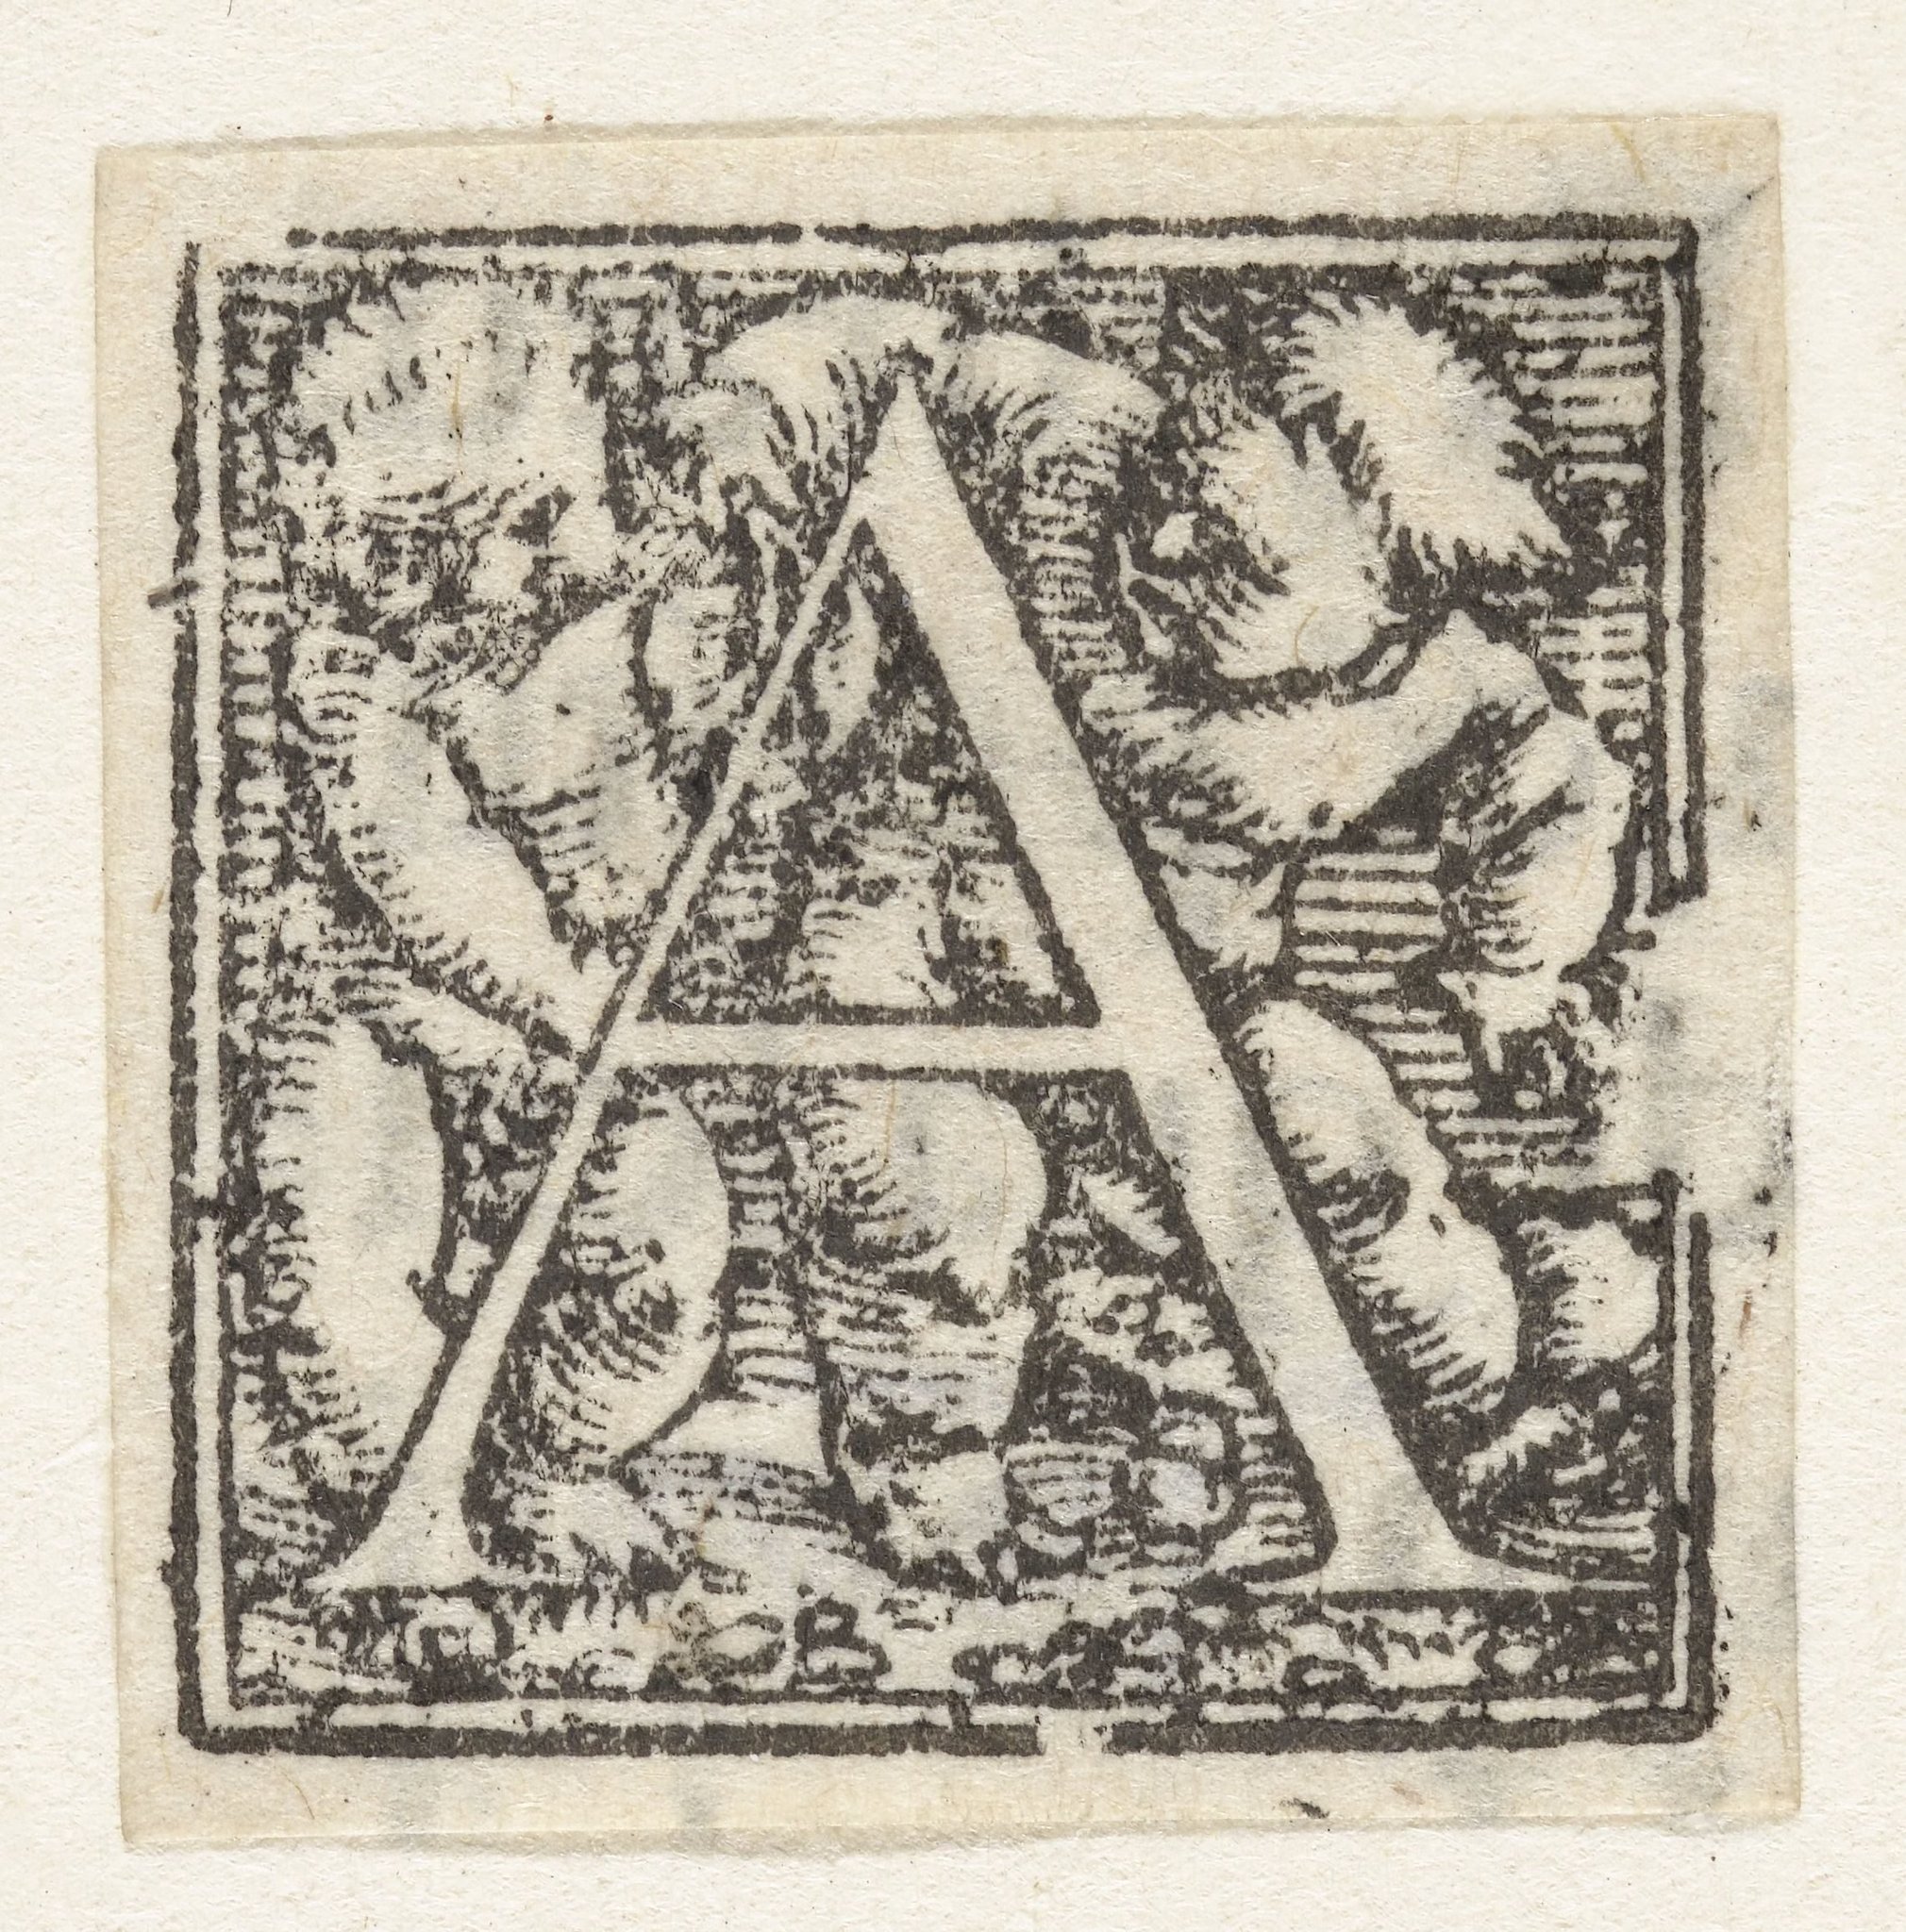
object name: print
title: Alfabet met kinderen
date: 1522-1526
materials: paper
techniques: woodcut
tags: letters, alphabet, script, child